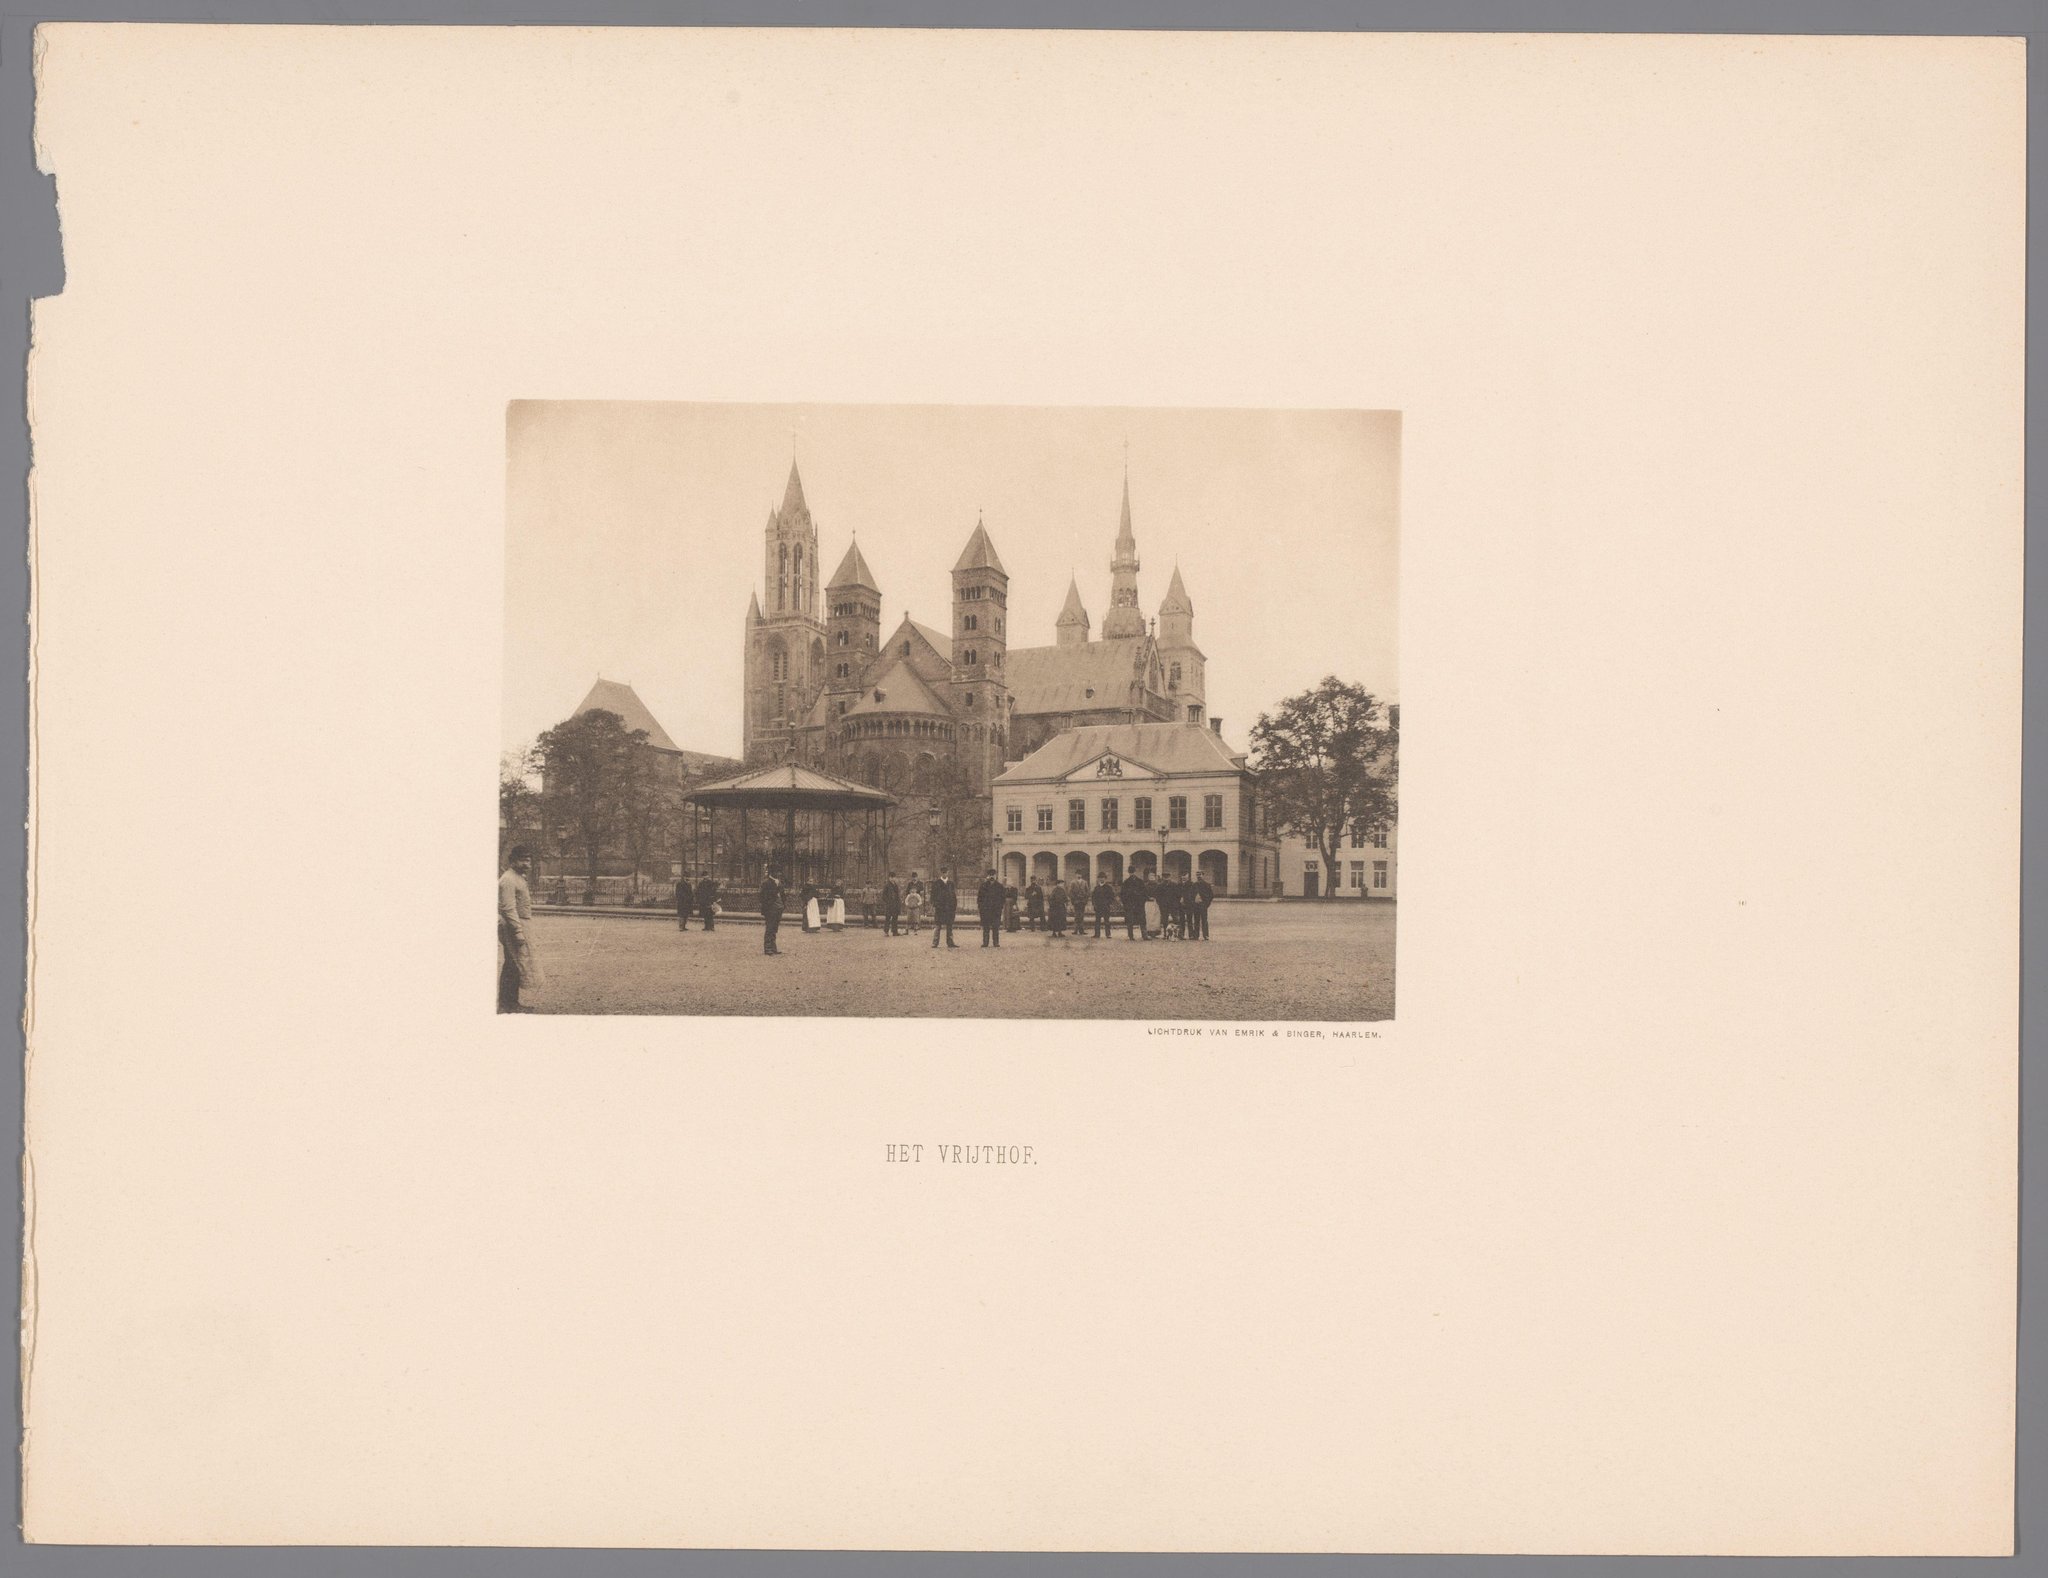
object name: photomechanical print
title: Gezicht op het Vrijthof te Maastricht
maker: anoniem (monumentenzorg)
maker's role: fotograaf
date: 1890-1910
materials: cardboard, paper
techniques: photograph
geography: maastricht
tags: square, place, circus, etc. (+ city(-scape) with figures, staffage)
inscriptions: collector's mark: ‘Rijksmuseum Amsterdam’